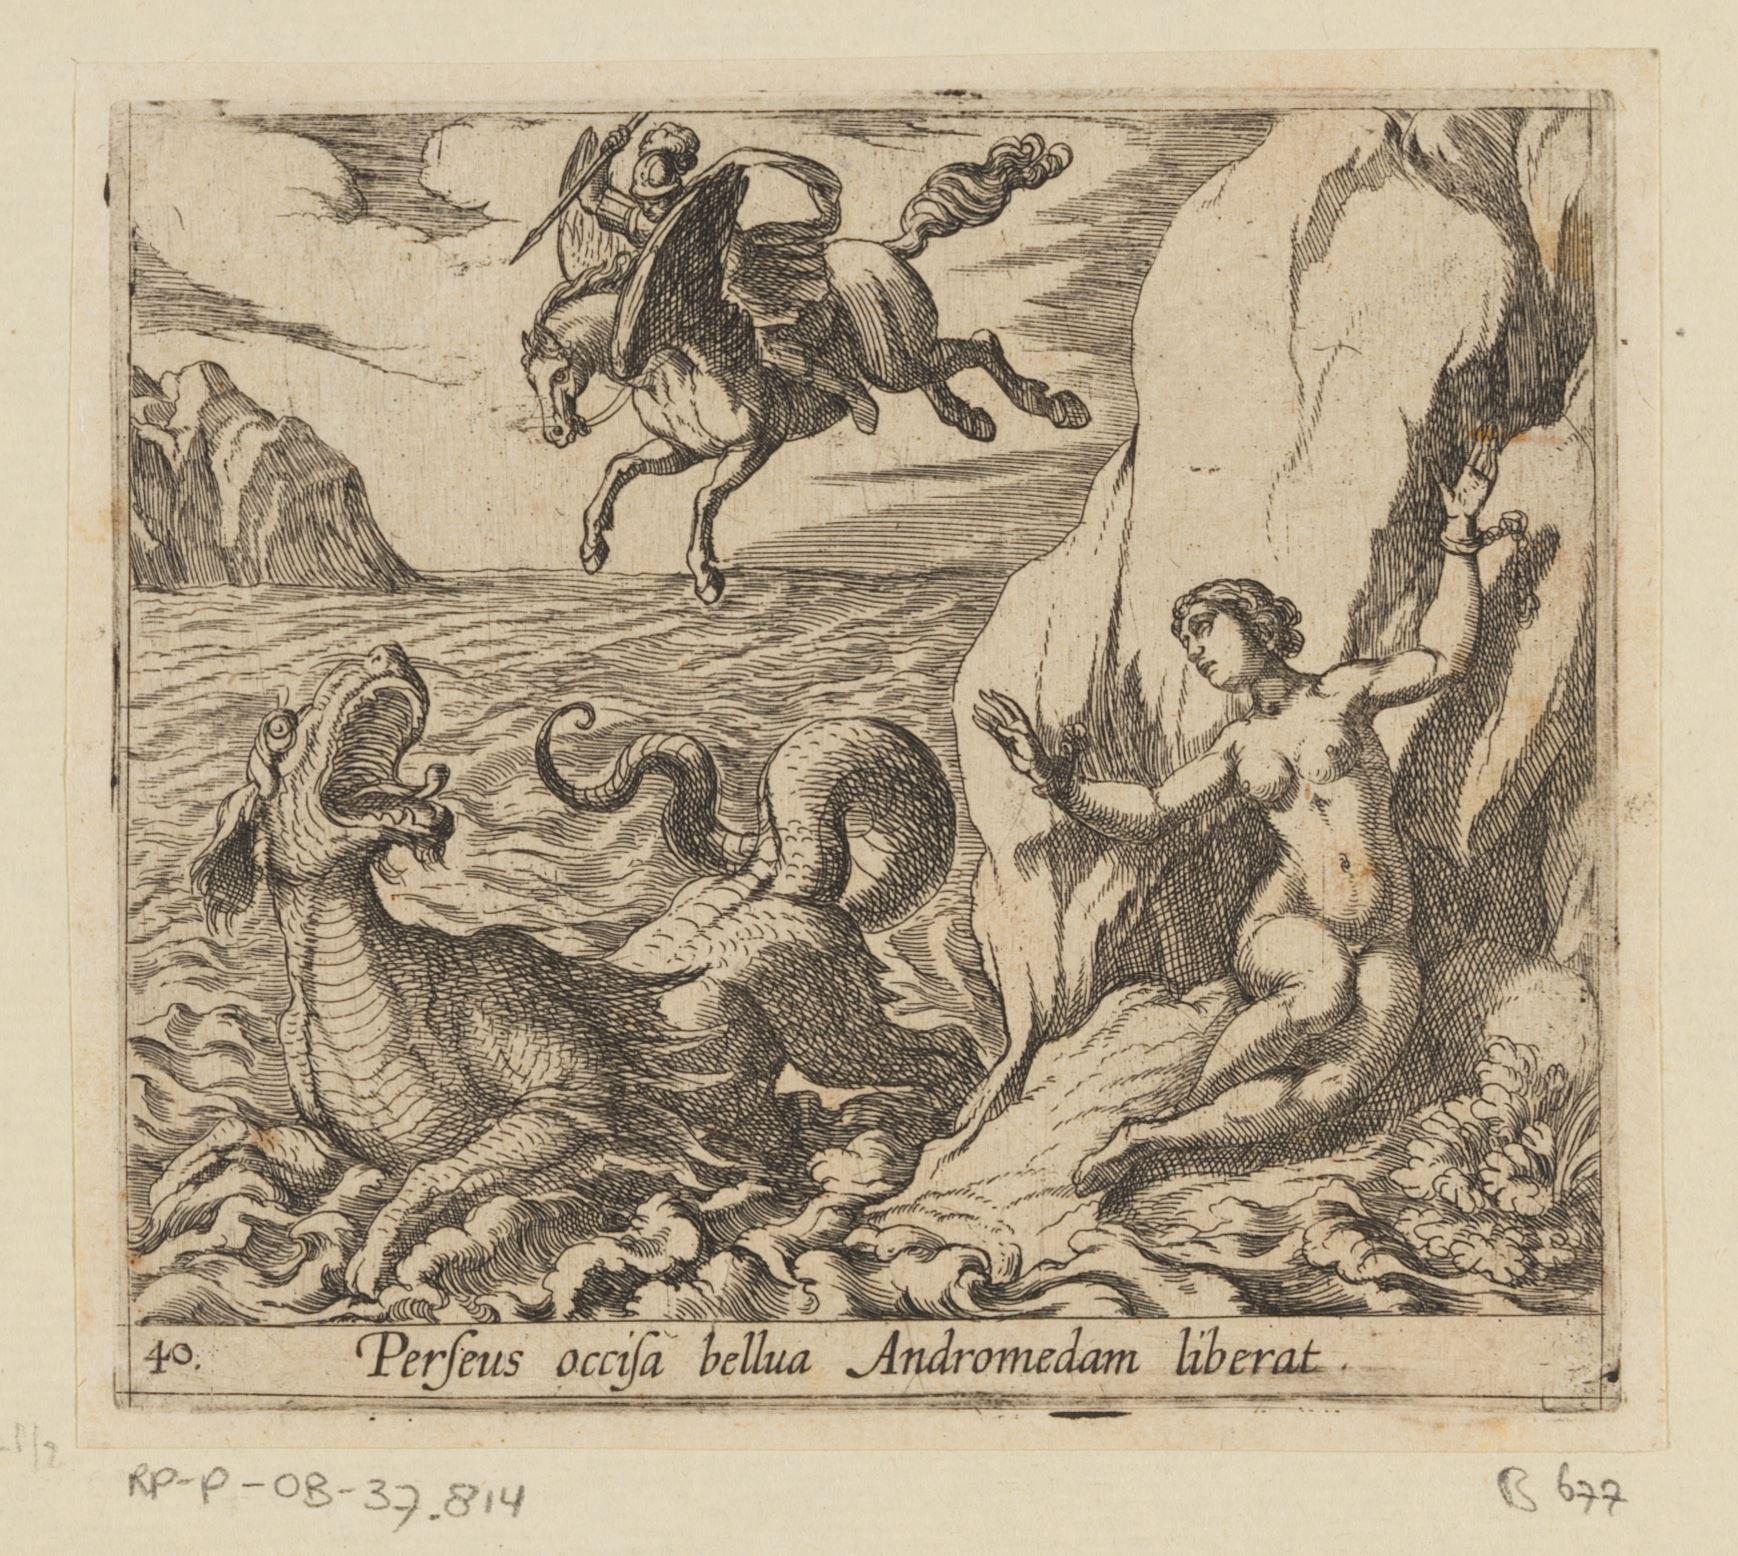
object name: print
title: Metamorphoseon sive transformationum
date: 1606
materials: paper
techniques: etching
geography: antwerp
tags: perseus and andromeda, andromeda chained to the rock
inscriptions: collector's mark: Lugt 240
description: Perseus komt aanvliegen op Pegasus om de vastgeketende Andromeda te redden van een zeemonster. Titel in het Latijn in ondermarge.